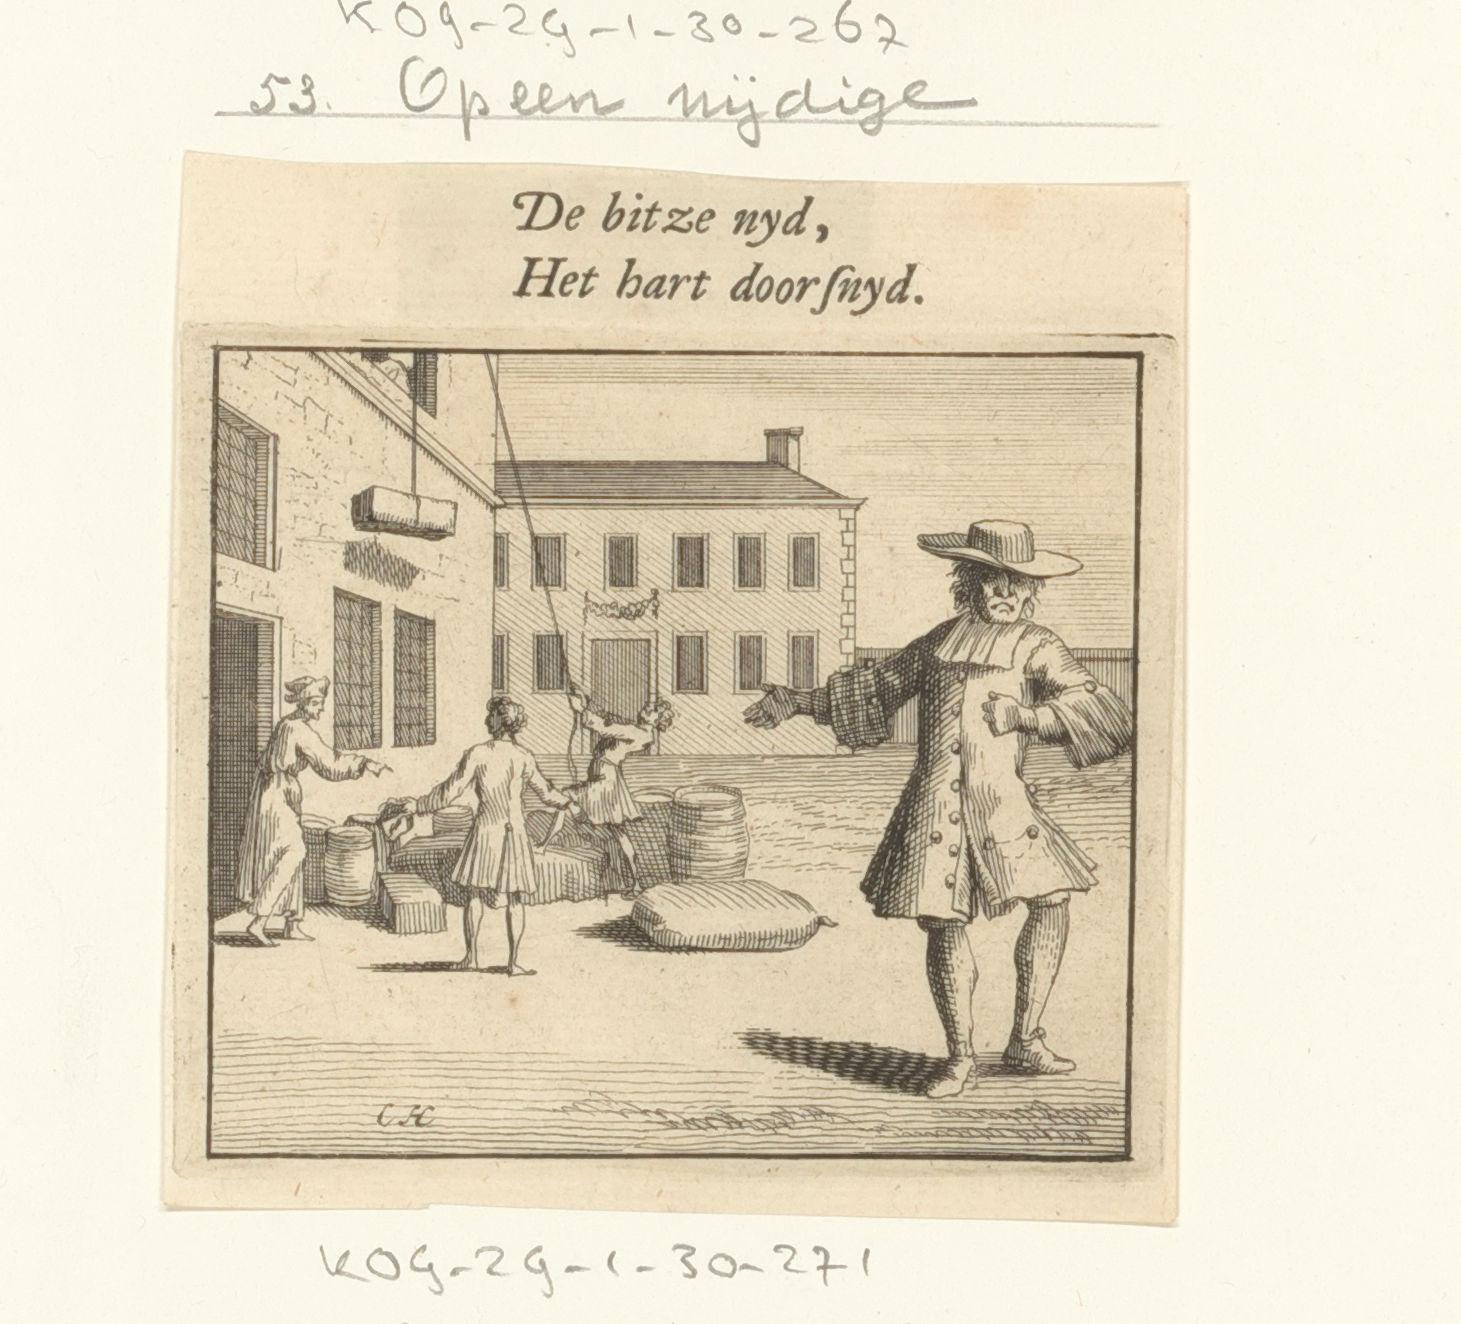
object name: print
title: De bitze nyd, Het hart doorsnyd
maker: cornelis huyberts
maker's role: print maker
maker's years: 1669-1709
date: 1725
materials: paper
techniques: etching, letterpress printing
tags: working class, labourers, rage, anger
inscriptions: stamp, collector's mark: Lugt 1641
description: Prent uit: Graauwhart, Hendrik. Voorbeeldelyke zeede-lessen, genoomen uyt den eersten toestand des werelds (...). Amsterdam: Johannes Ratelband, 1725. Prent ook gebruikt voor eerdere en (1709) latere uitgave (1756, 1761 en 1764).